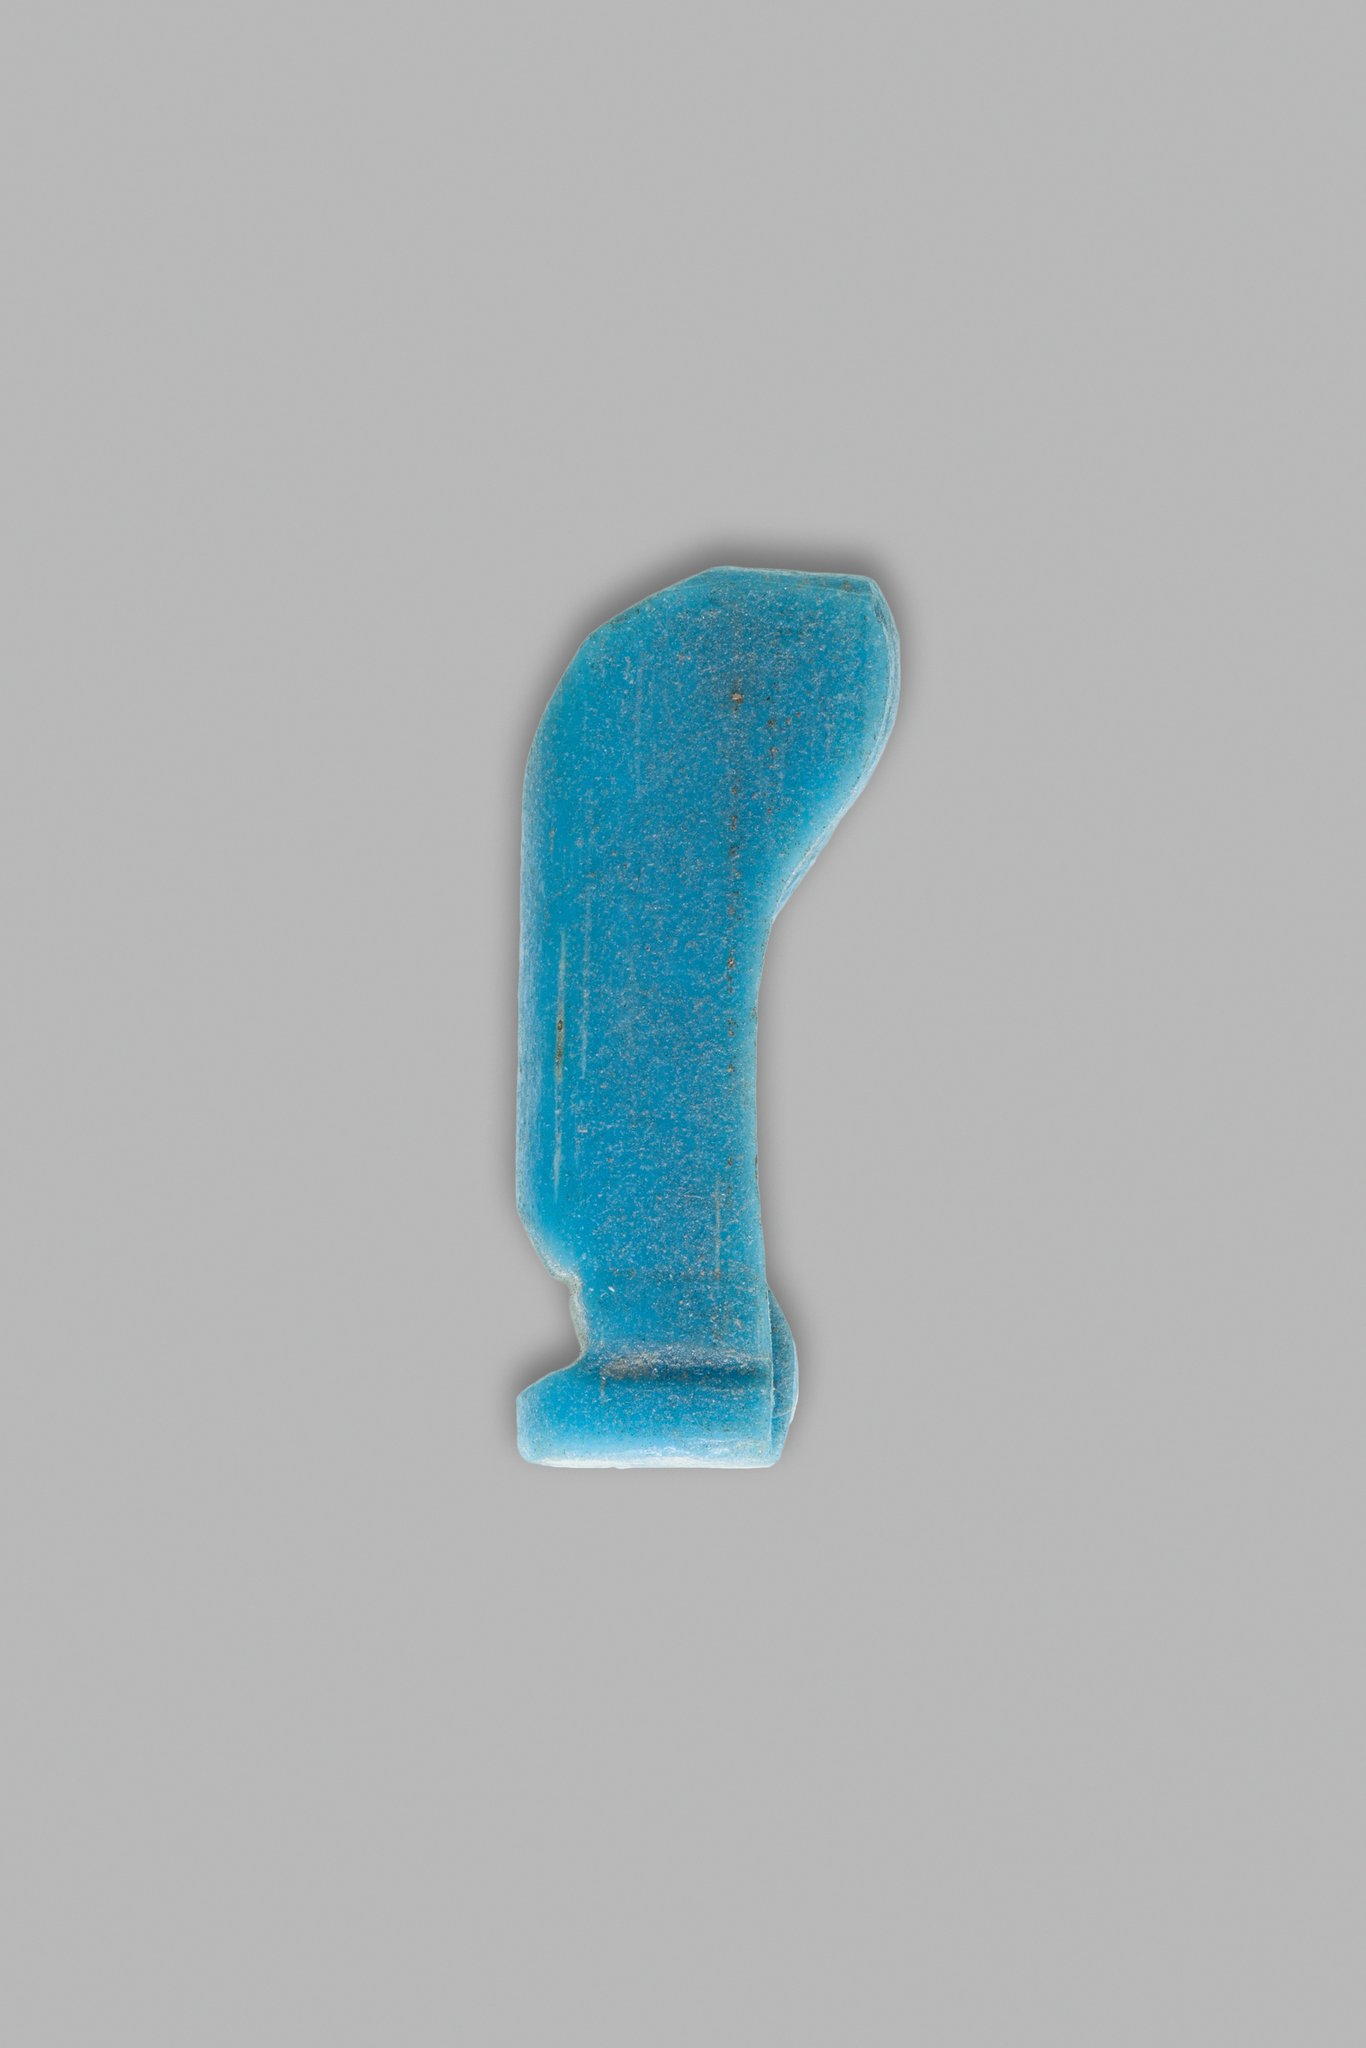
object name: foundation deposit, plaque, rectangular, ramesses iv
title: Cartouche-Shaped Plaque Fragment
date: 1153-1147 BCE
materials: glass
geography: egypt